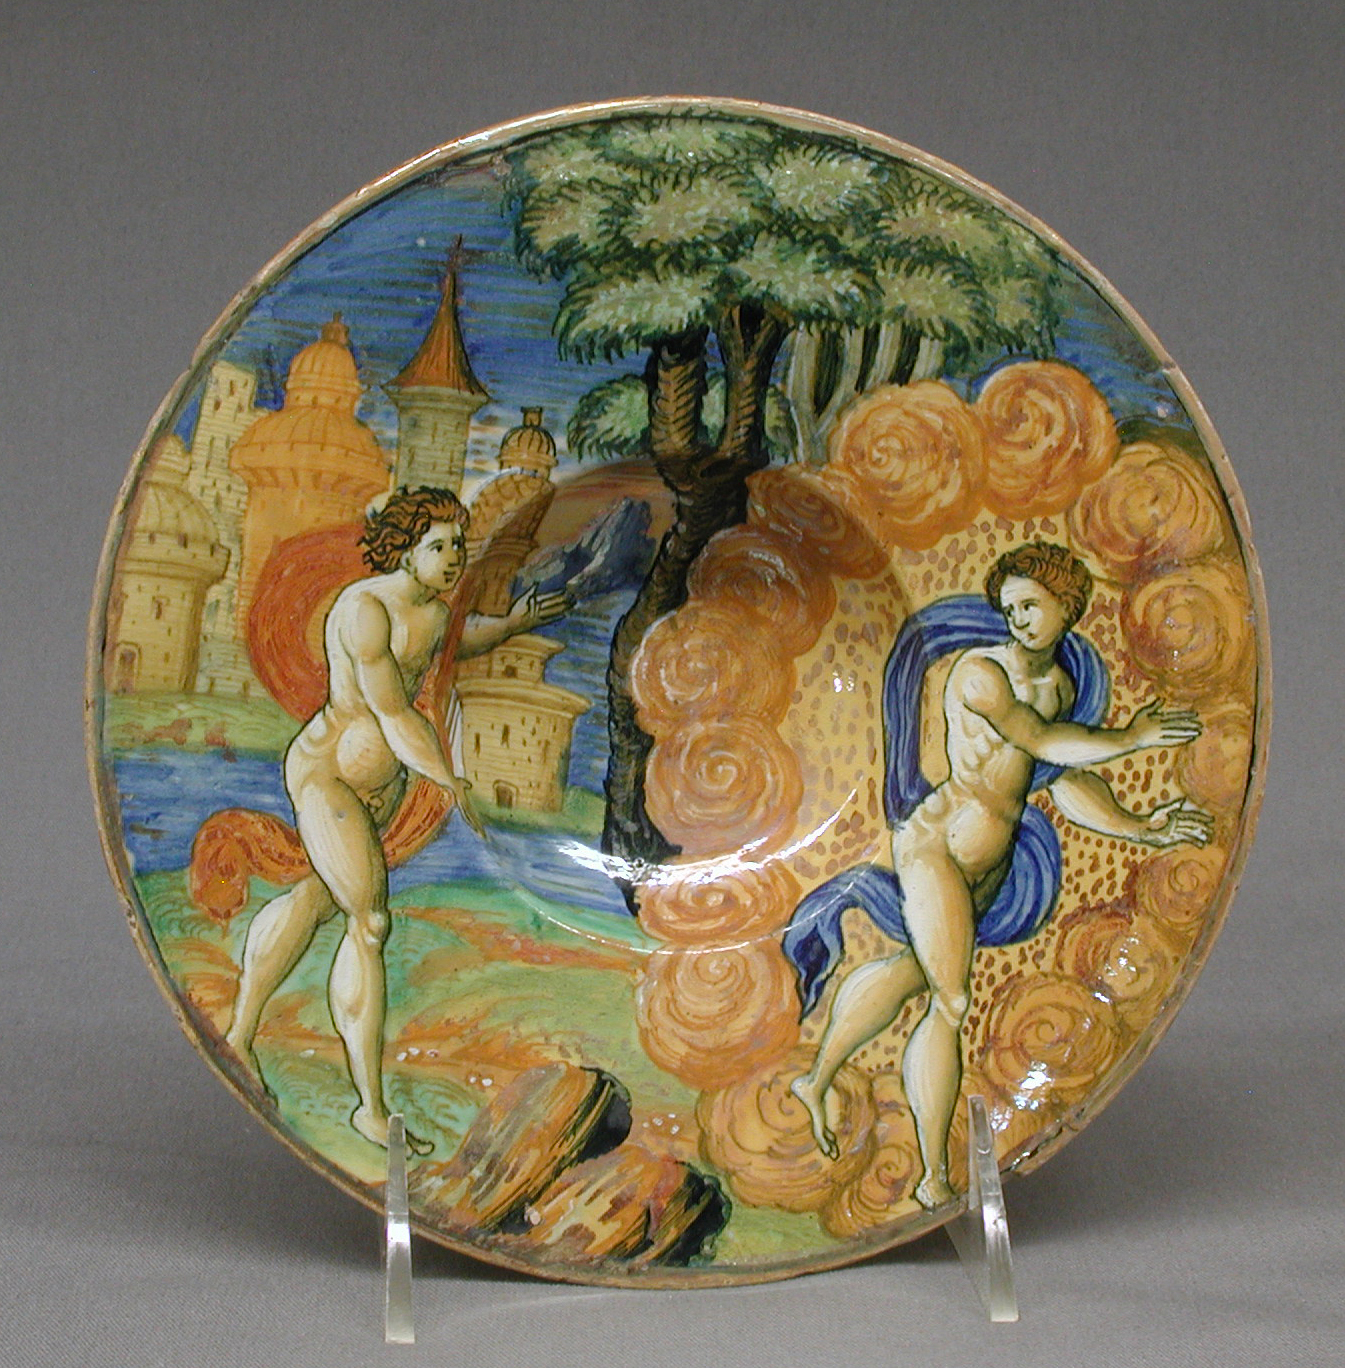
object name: plate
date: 1530-1550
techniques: maiolica, glazing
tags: male nudes,female nudes